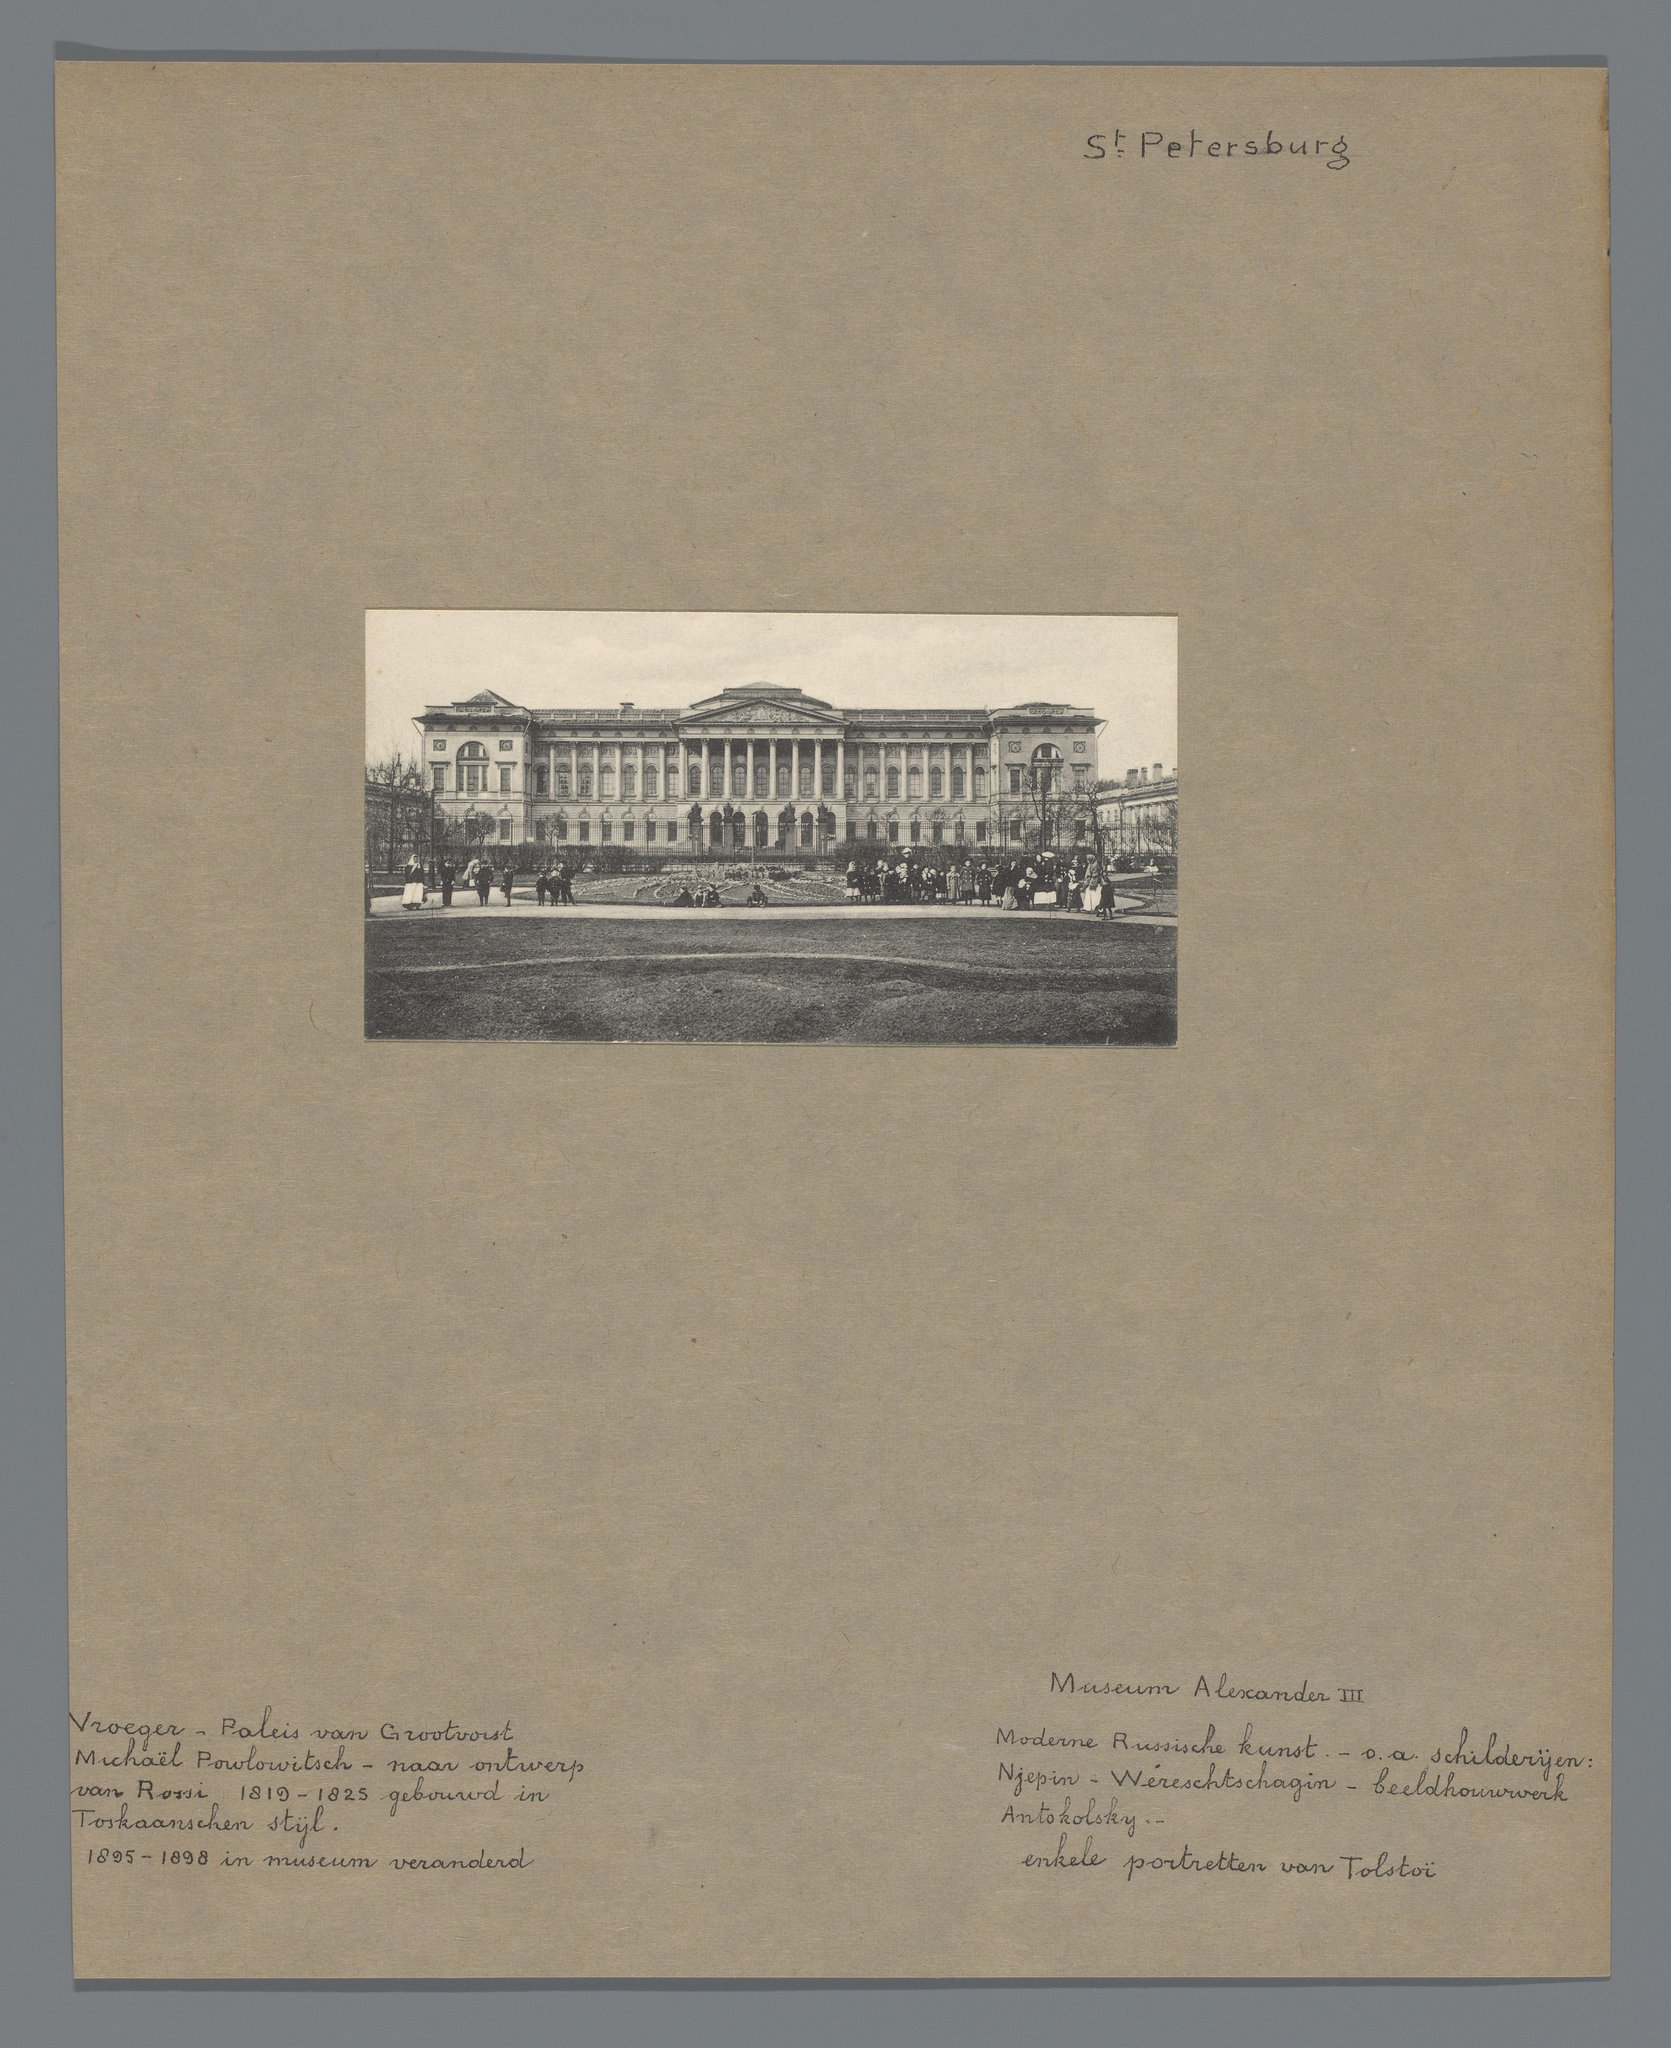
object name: photograph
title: St. Petersburg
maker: Anonymous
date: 1860-1925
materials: photographic support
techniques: photograph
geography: russia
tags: sint-petersburg